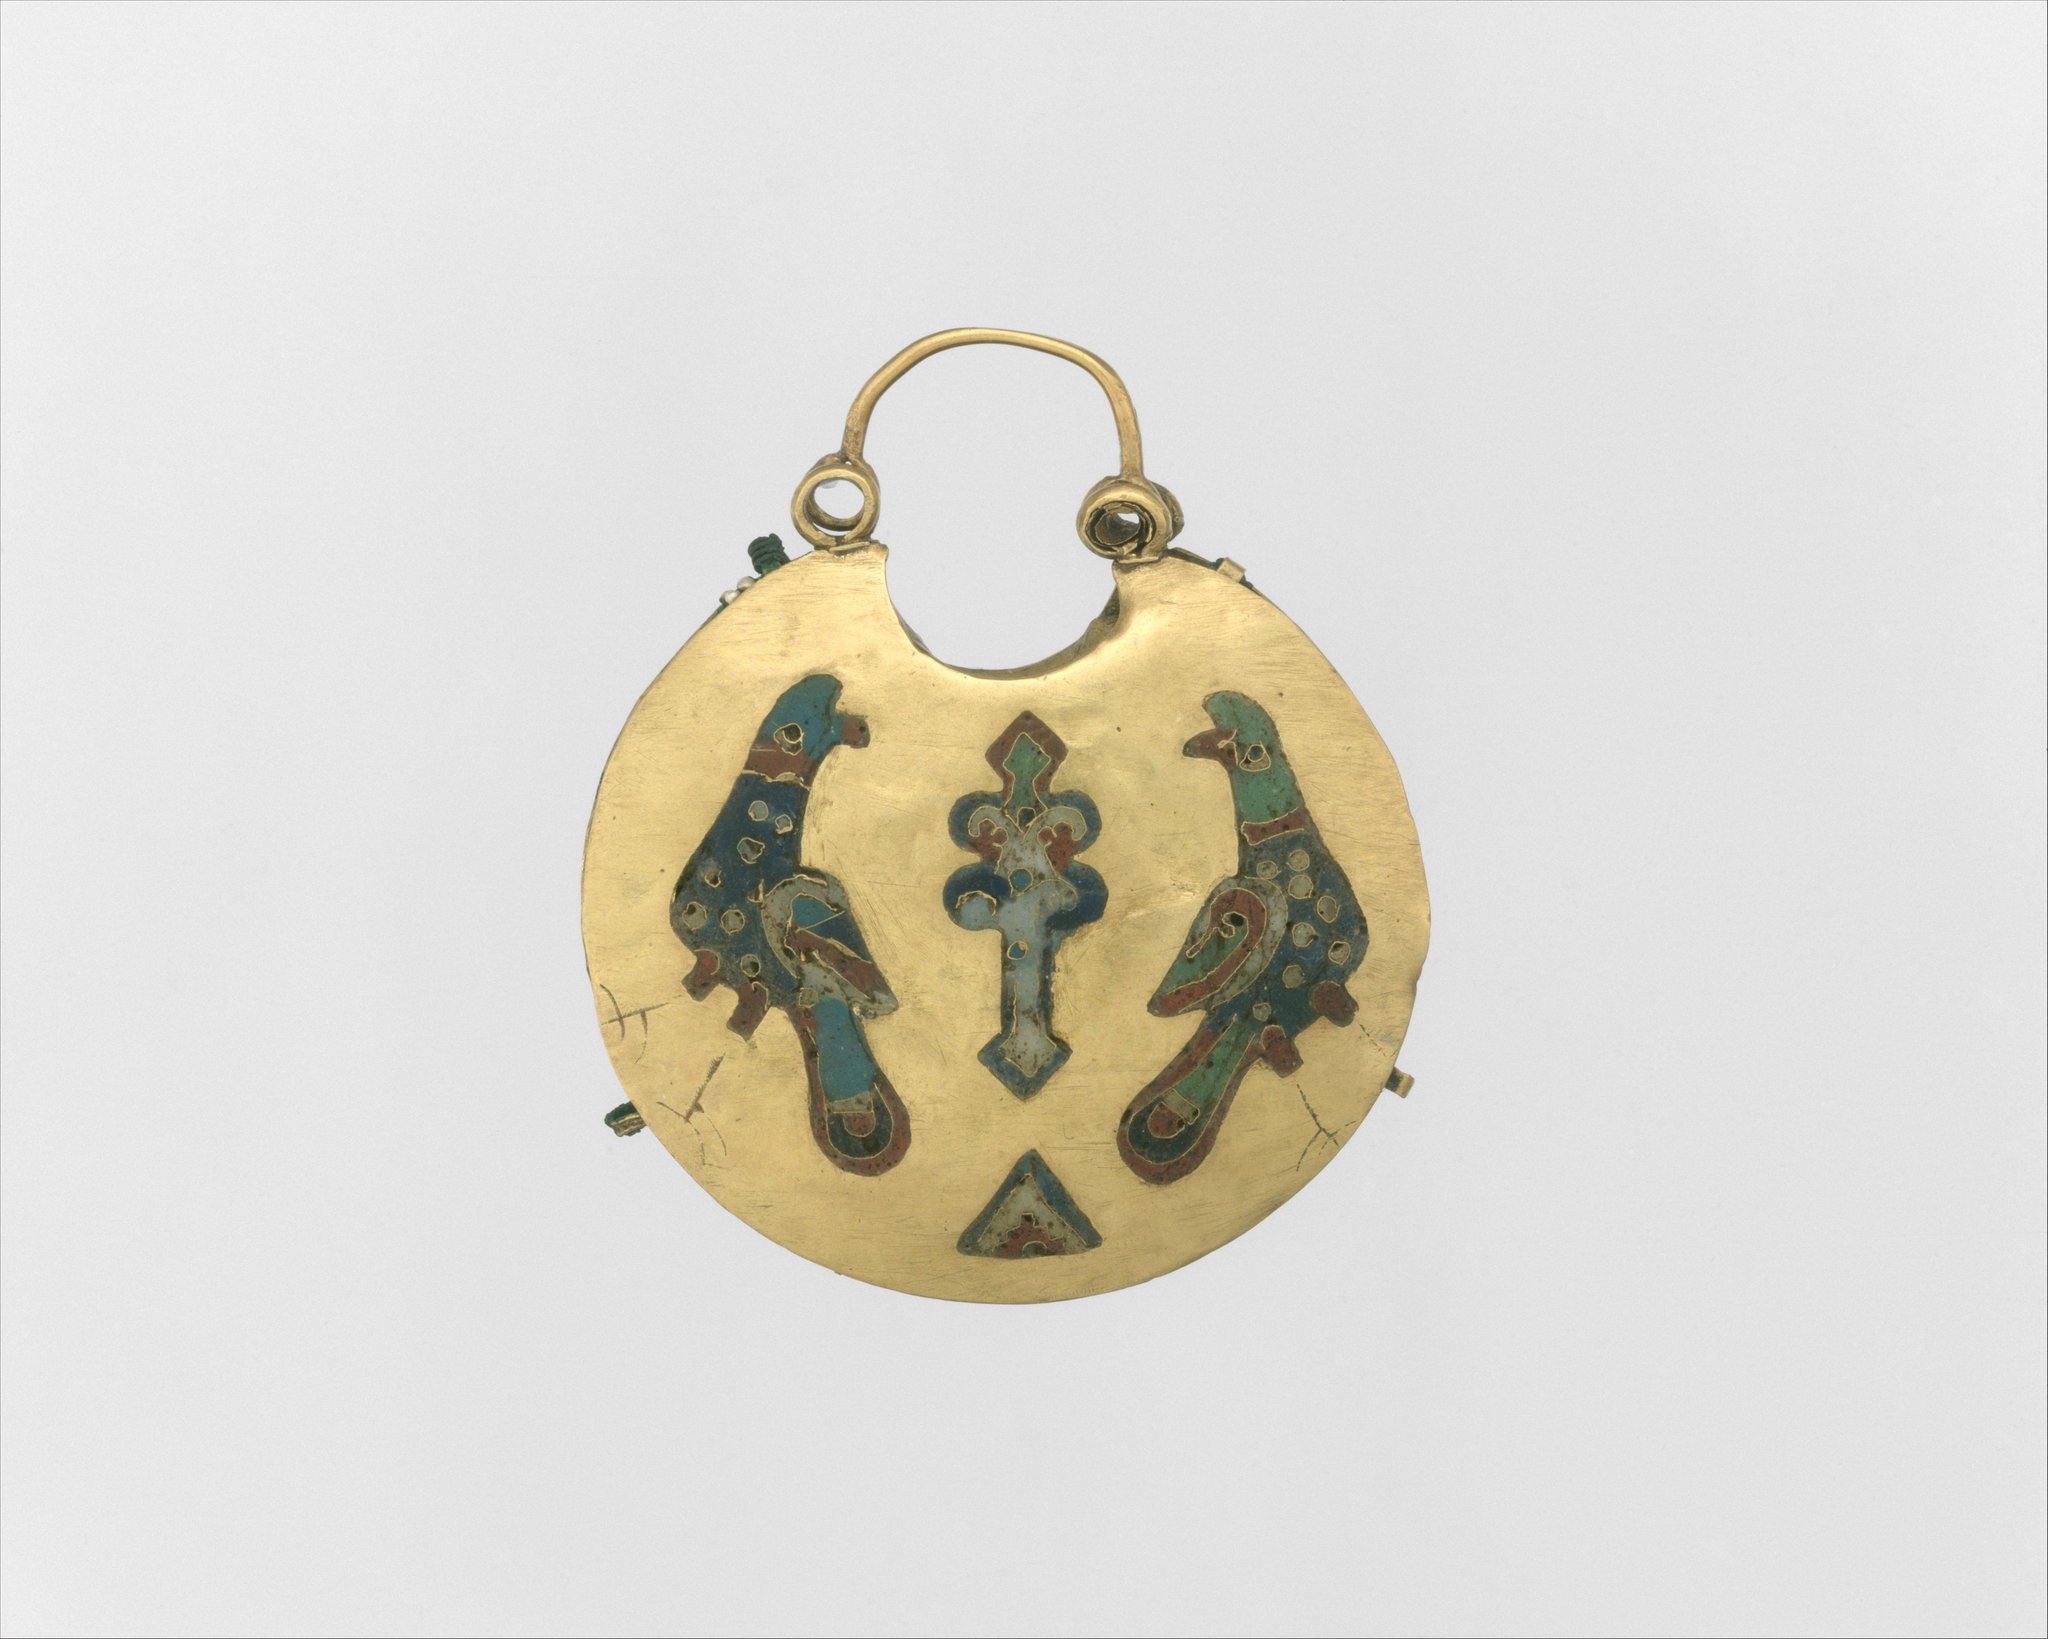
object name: temple pendant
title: One of a Pair of Temple Pendants, with Two Birds Flanking a Tree of Life (front) and Leaf and Rosette Motifs (back)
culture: kyivan rus’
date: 1001-1200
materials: enamel, gold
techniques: enamel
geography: ukraine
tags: birds